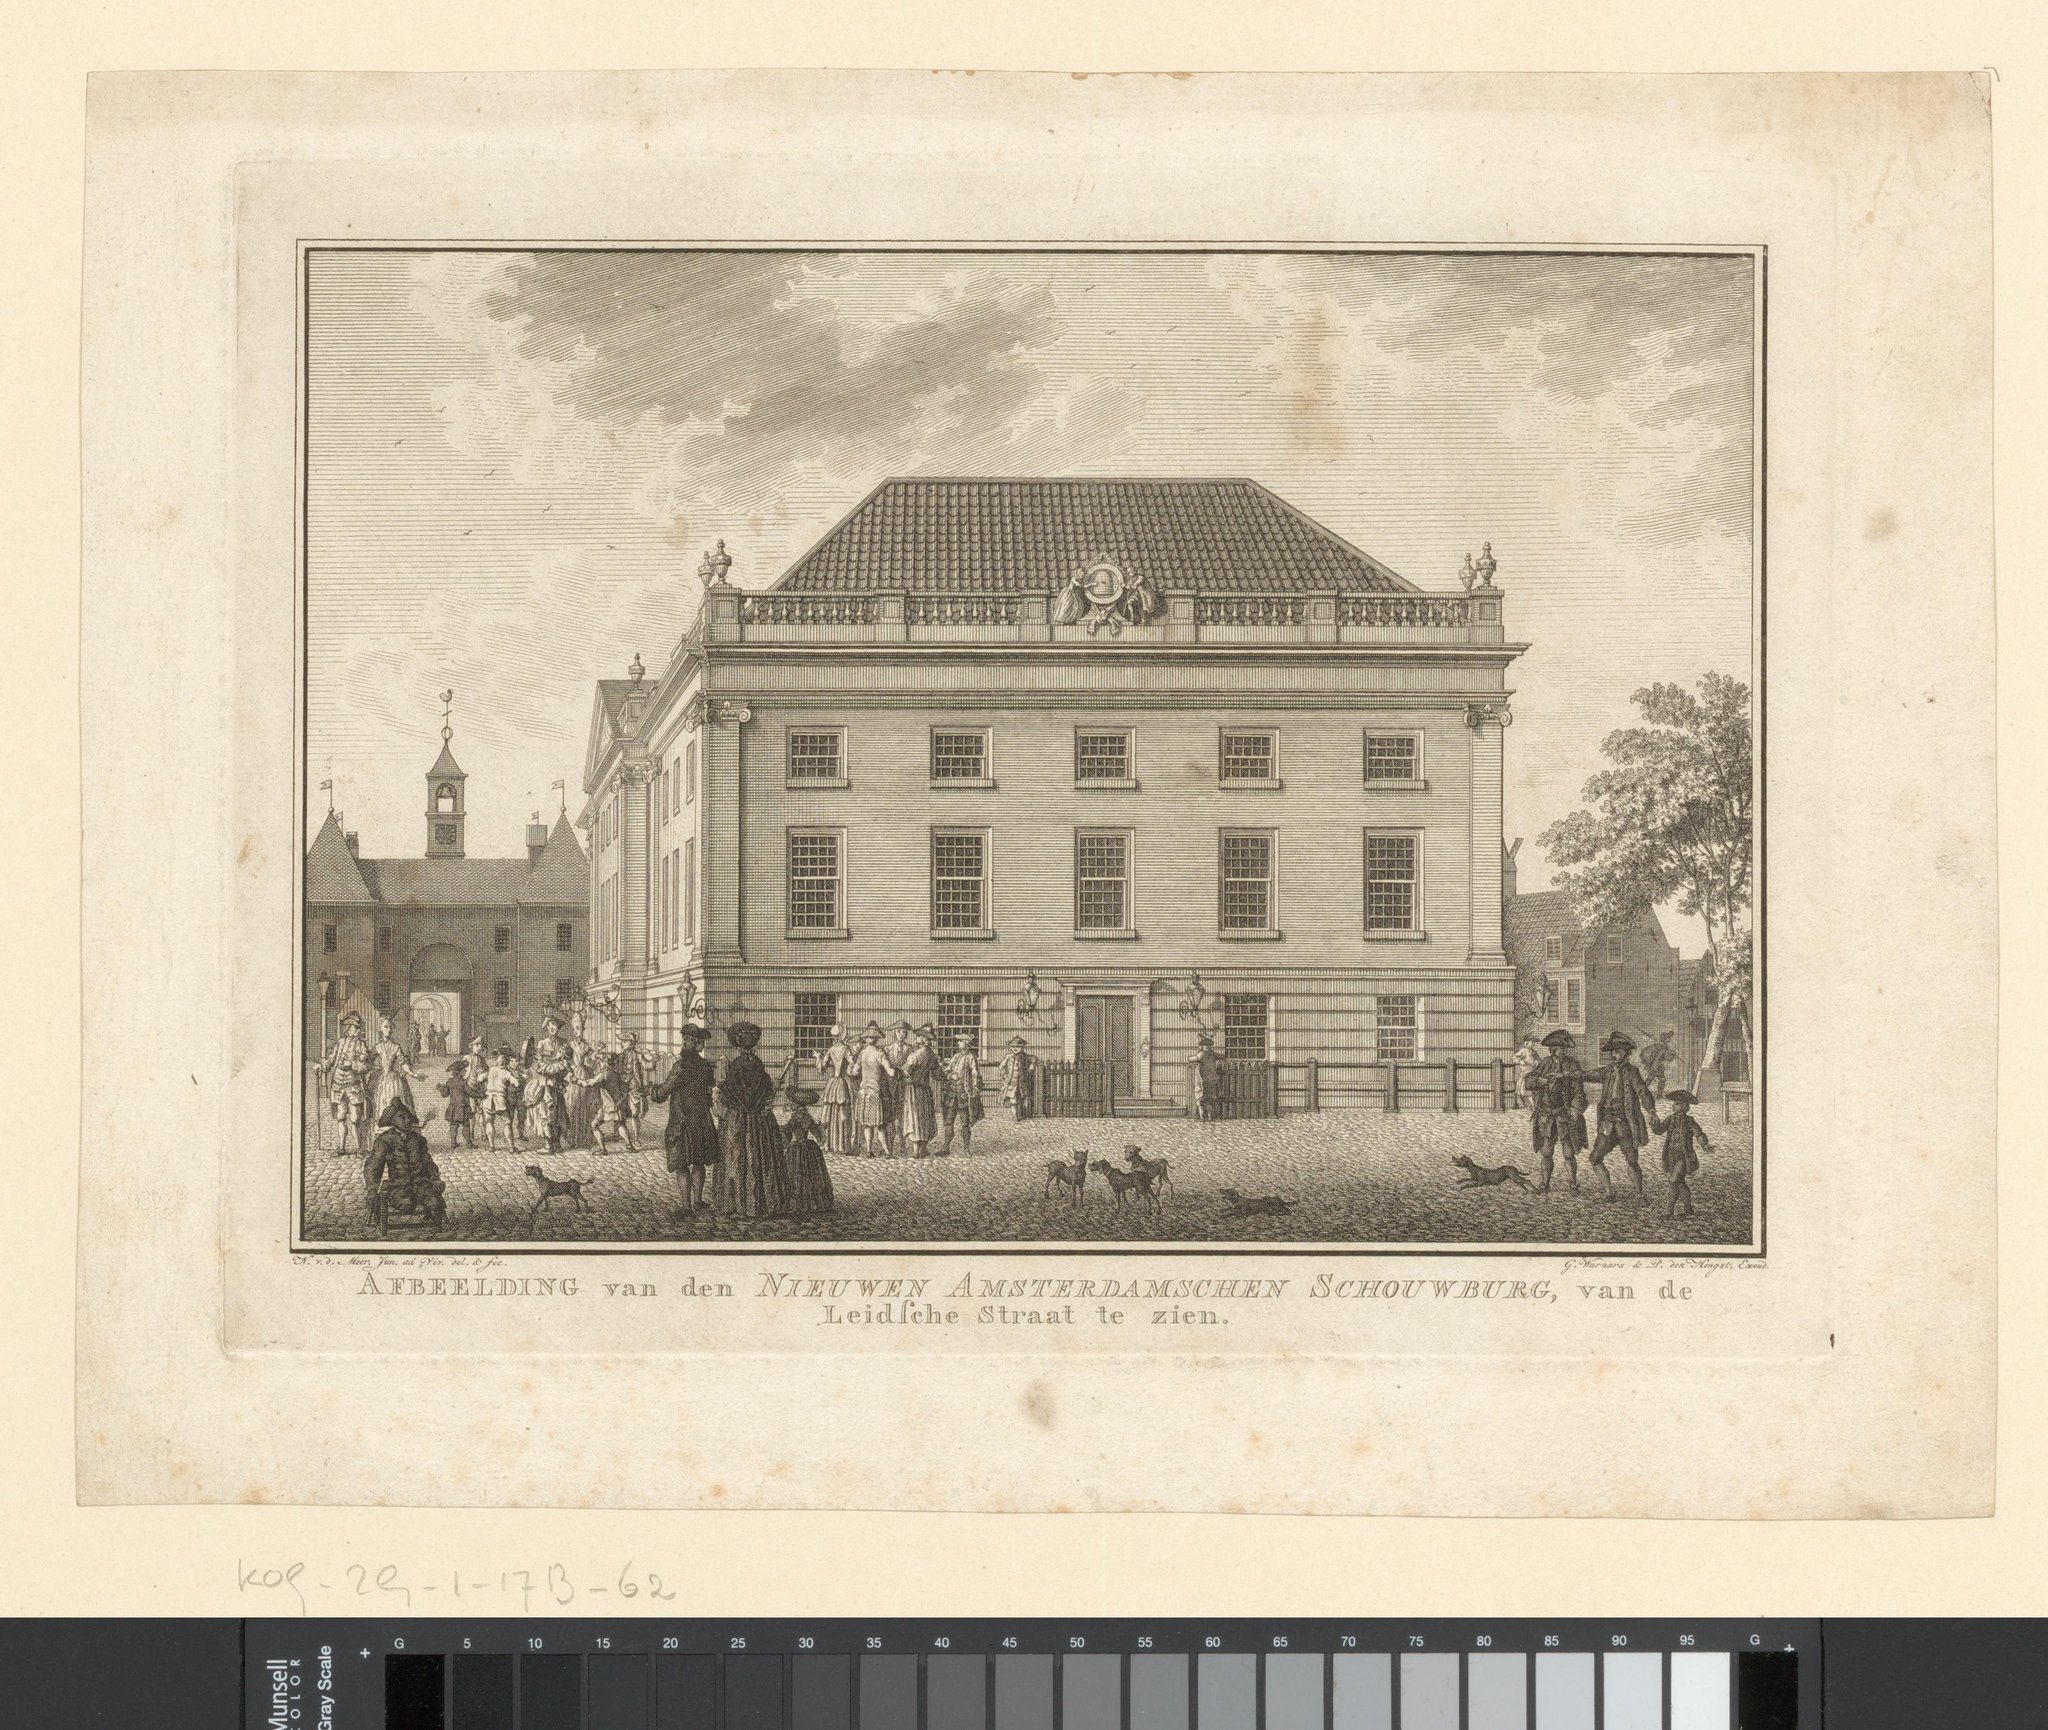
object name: book illustration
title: Gezicht op de zijkant van de schouwburg aan het Leidseplein te Amsterdam, 1774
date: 1774-1775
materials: paper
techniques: engraving, etching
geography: amsterdam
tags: square, place, circus, etc., theatre (building), city-gate, amsterdam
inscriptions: stamp, collector's mark: Lugt 1641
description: Gezicht op de zijkant van de op 15 september 1774 ingewijde Amsterdamse Schouwburg op het Leidseplein, gezien vanuit de Leidsestraat. Links op de achtergrond de Leidsepoort. Deze stadsschouwburg werd gebouwd om de in 1772 afgebrande schouwburg aan de Keizersgracht te vervangen en brandde in 1890 zelf af. Links op de voorgrond zit Swarte Klaas op zijn krukje pijp te roken. Rechts achter hem staat Prulla, een ander bekend straatfiguur uit die tijd, met haar spreektrompet. Onderwerpsrubrieken binnen de Atlas Zeden en Gewoonten: Schoone kunsten, Tooneel, Schouwburg op het Leidscheplein (sedert 1774).